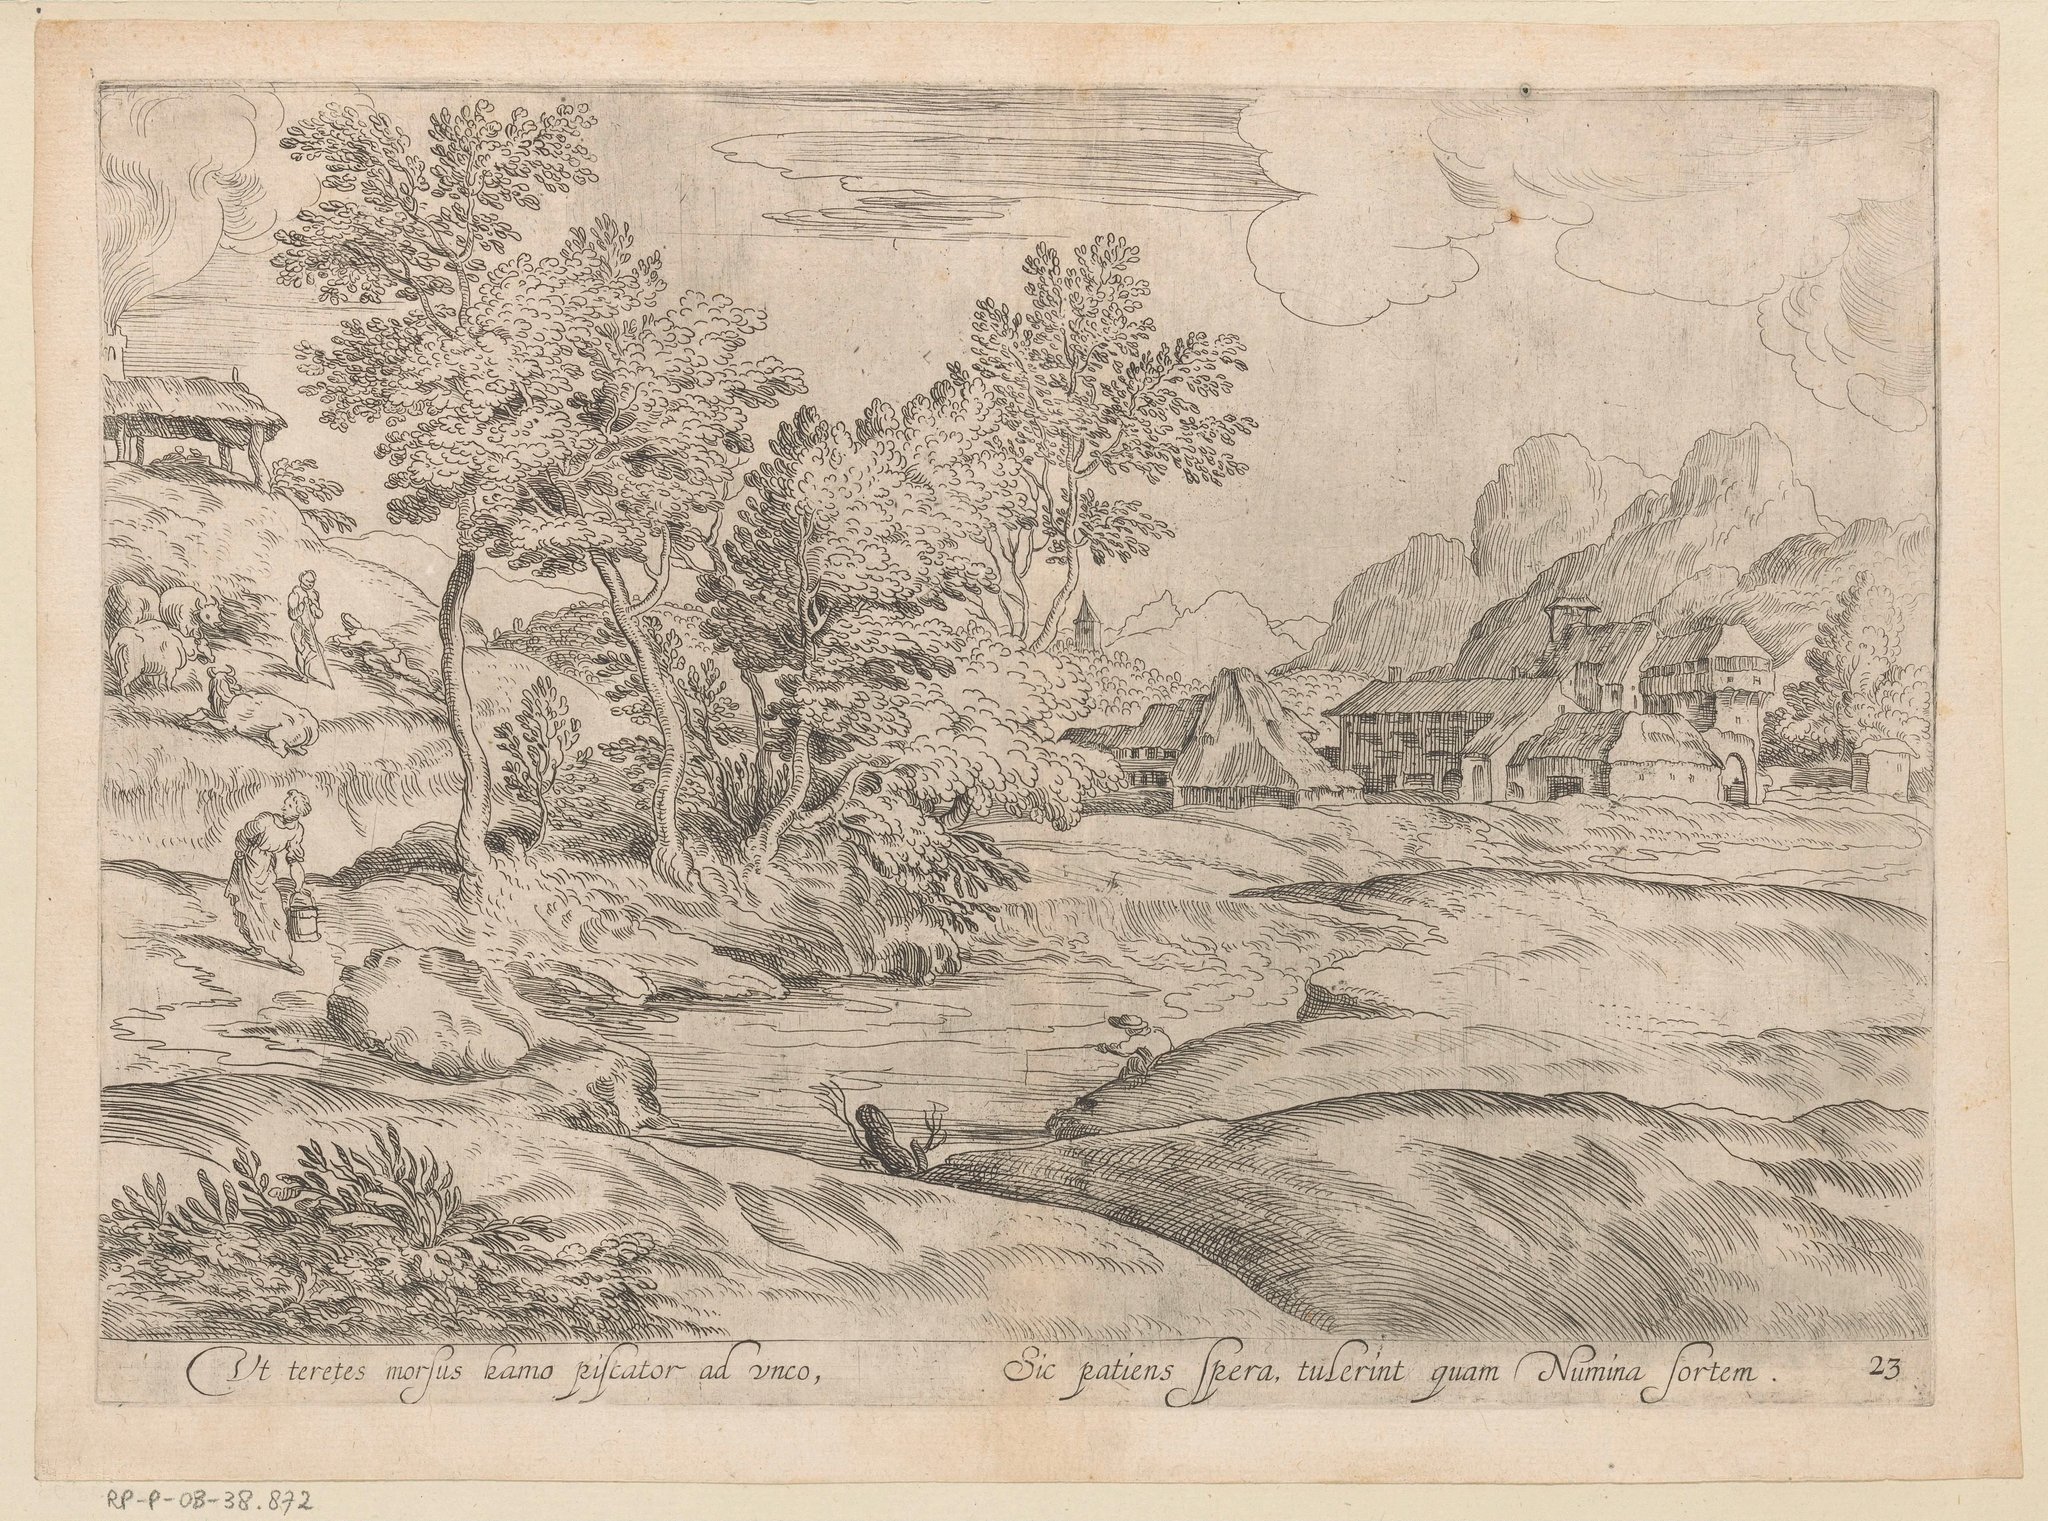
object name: print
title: Landschappen naar Domenico Campagnola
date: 1600-1699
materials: paper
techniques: etching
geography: italy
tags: landscapes, herding, herdsman, herdswoman, shepherd, shepherdess, cowherd, etc., village, herd, flock, fisherman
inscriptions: collector's mark: Lugt 2228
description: Heuvellandschap met rivier. Op de achtergrond rechts een dorp. Links een herder en herderin met ossen. Op de voorgrond een visser aan de waterkant. Titel in het Latijn in ondermarge. Genummerd rechtsonder: 23.